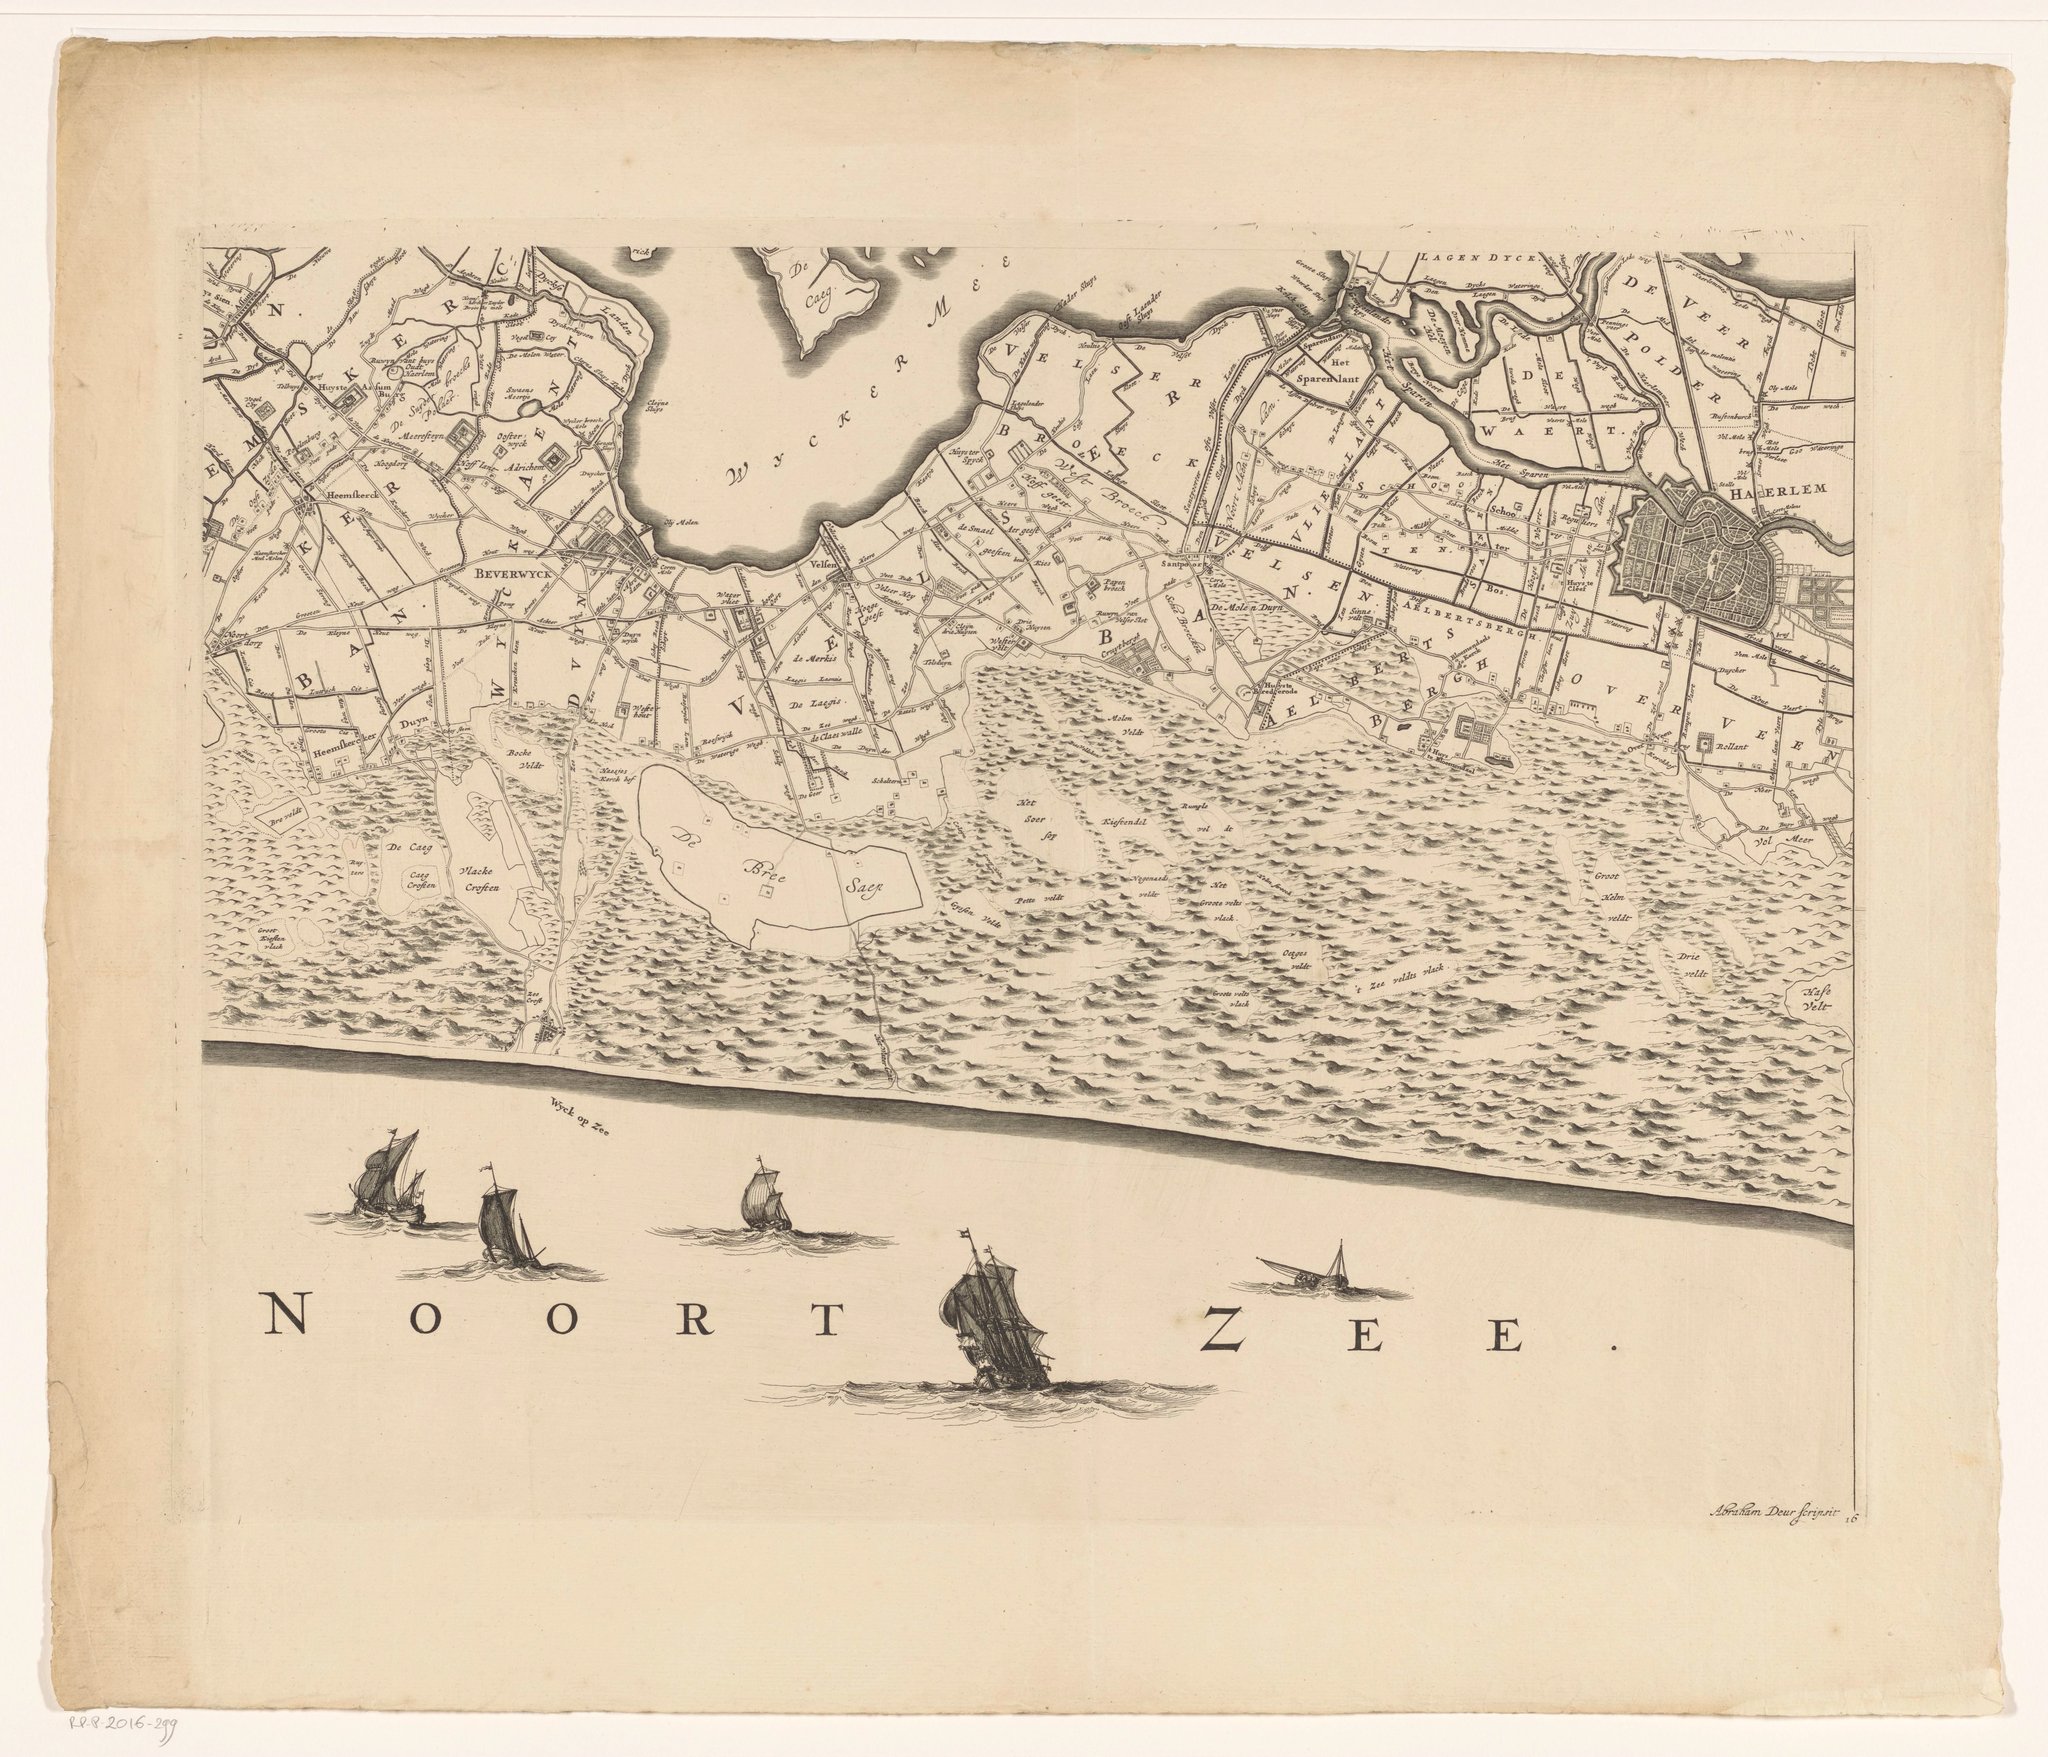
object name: print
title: Kaart van Kennemerland en West-Friesland (zestiende deel)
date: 1680-1811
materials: paper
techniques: engraving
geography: amsterdam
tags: maps of separate countries or regions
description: Deze prent is oorspronkelijk onderdeel van een zestiendelige wandkaart van Kennemerland en West-Friesland, gemaakt door landmeter Jan Jansz Dou in opdracht van het Hoogheemraadschap van de Uitwaterende Sluizen in Kennemerland en West-Friesland. Voor een volledige versie van deze kaart zie: RP-P-AO-6-26. Voor een ander exemplaar van dit blad zie: RP-P-AO-6-26-16 en RP-P-1939-1434. Van deze kaart zijn drie staten bekend waarvan de eerste verscheen in 1680 bij uitgever Jan Karels te Amsterdam, de tweede in 1729 bij Andries en Hendrik de Leth te Amsterdam en de derde in 1745 bij Isaak Tirion te Amsterdam. De derde staat werd in 1811 nogmaals gedrukt bij A. Koning te Amsterdam. De verschillende staten van de kaart zijn te dateren aan de hand van de namen van de dijkgraaf, hoogheemraden en rentmeester die te vinden zijn op de bovenste bladen van de kaart. Aangezien het huidige exemplaar een los blad is van de onderste rij bladen van de kaart kan het niet precies gedateerd worden. Vlak na het verschijnen van de wandkaart werd besloten tevens een vierblads (RP-P-AO-6-25A, RP-P-AO-6-25B, RP-P-AO-6-25C en RP-P-AO-6-25D) en een éénblads uitgave (RP-P-AO-6-24-1 en RP-P-AO-6-24-2) te laten maken. Alle drie de kaarten werden gegraveerd door Coenraet Decker en Abraham Jansz. Deur, die verantwoordelijk was voor het graveren van de letters.